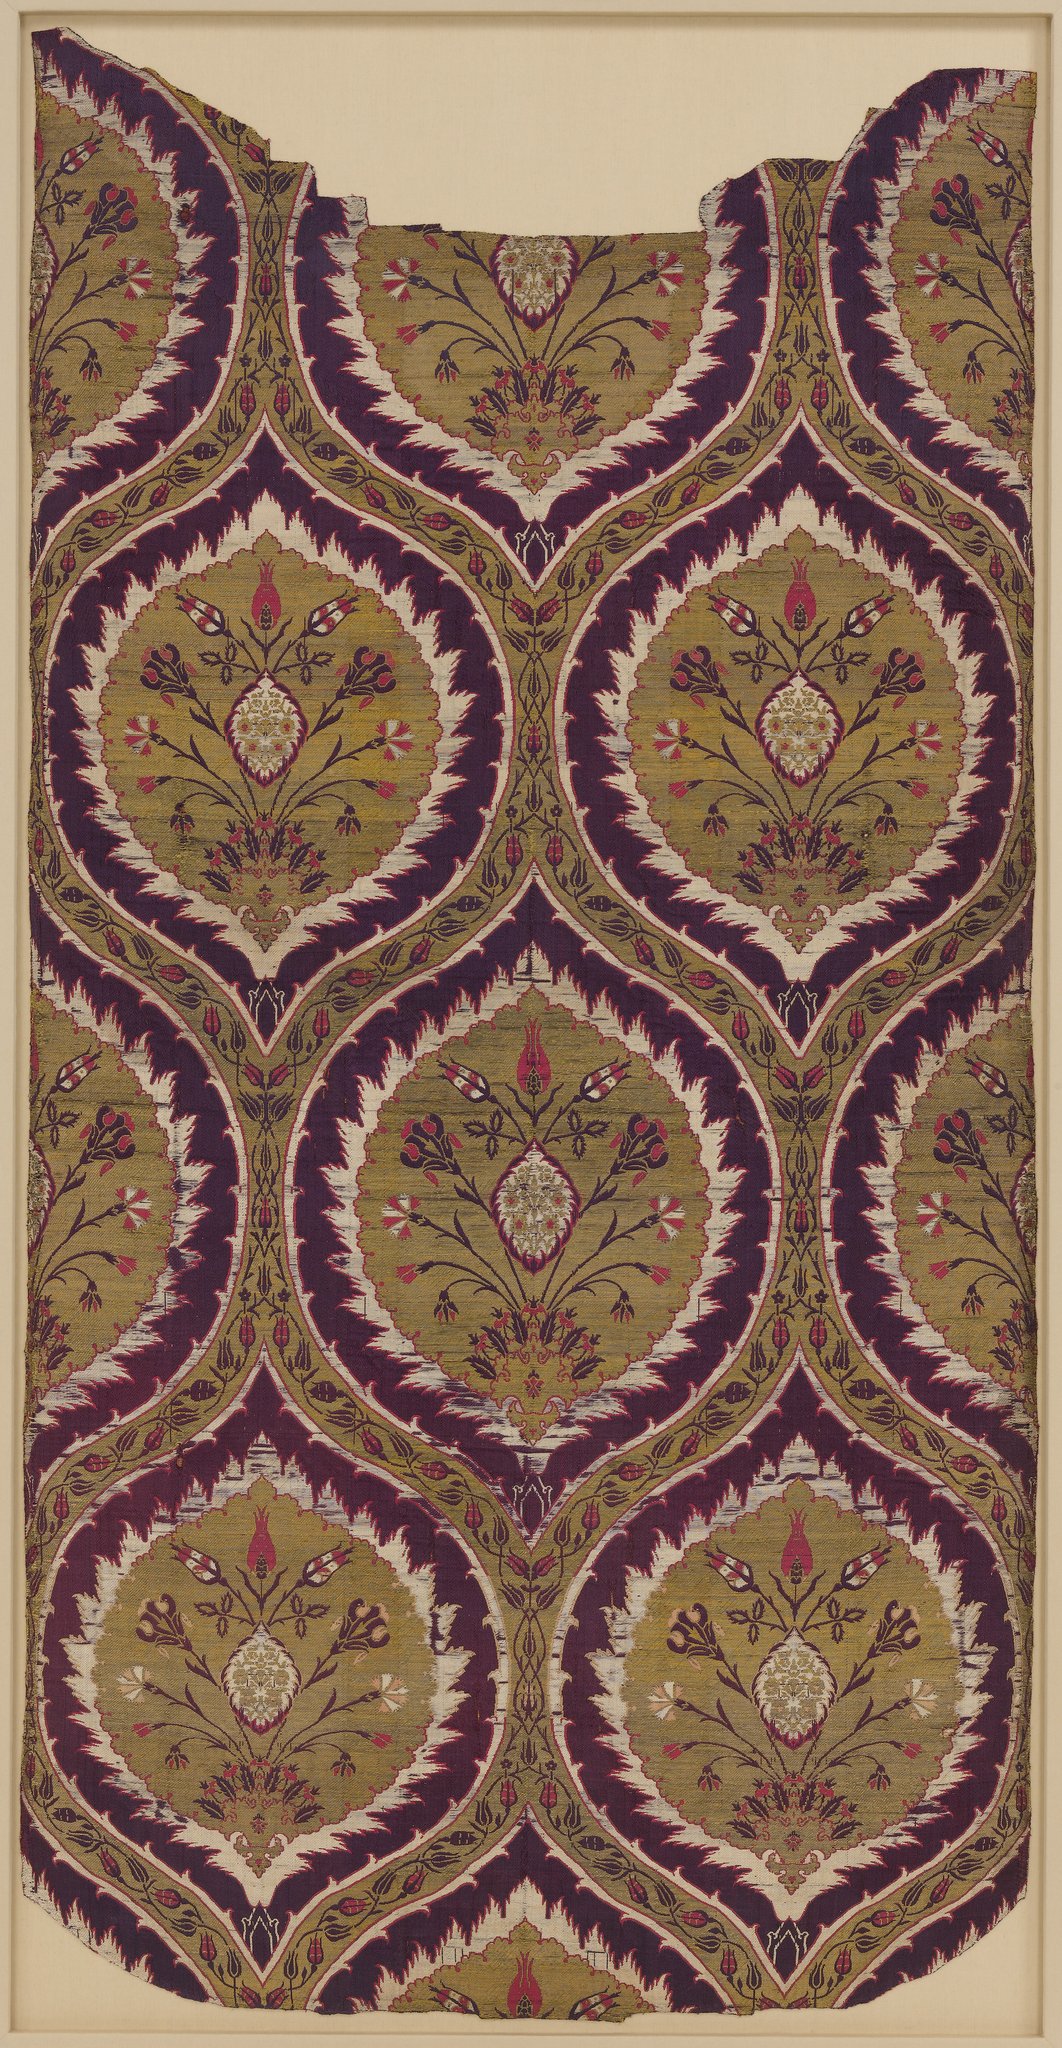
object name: textile fragment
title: Fragmentary Loom Width with Ogival Pattern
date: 1570-1580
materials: metal thread, silk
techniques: lampas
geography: turkey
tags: flowers